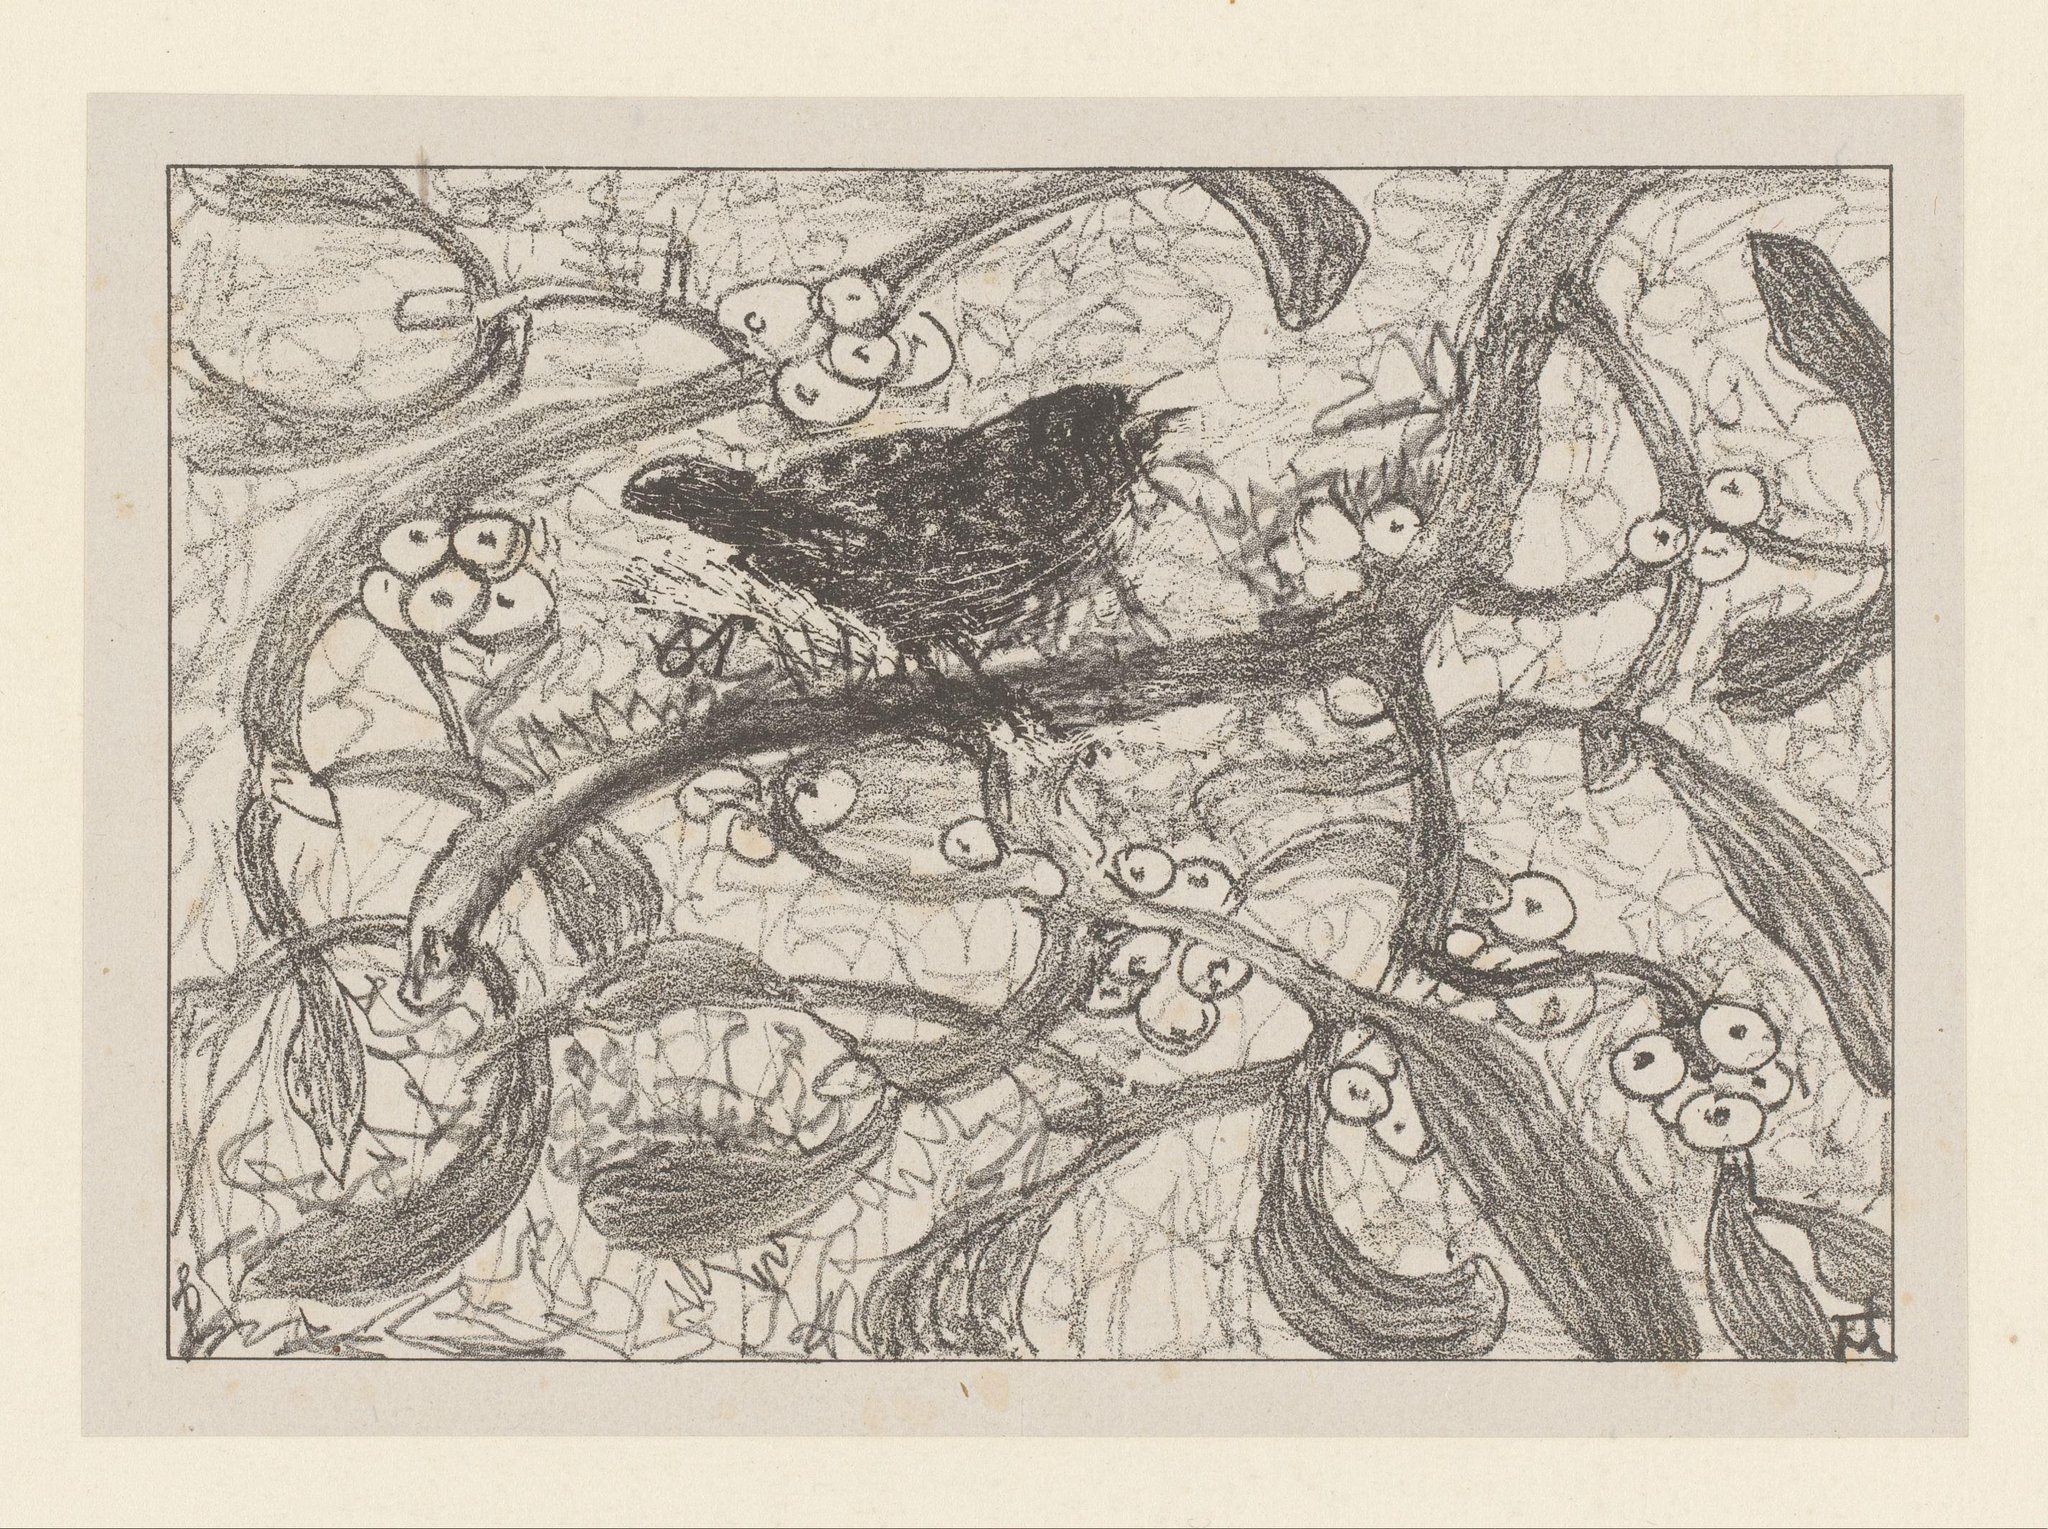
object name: print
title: Winterkoninkje op maretak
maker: theo van hoytema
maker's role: draughtsman, painter, print maker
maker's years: 1863-1917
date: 1878-1917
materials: paper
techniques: lithograph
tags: plants and herbs: mistletoe, song-birds: wren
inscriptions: collector's mark: Lugt 2228, collector's mark: Lugt 4731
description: Prent is een proefdruk voor kalenderblad december 1918.